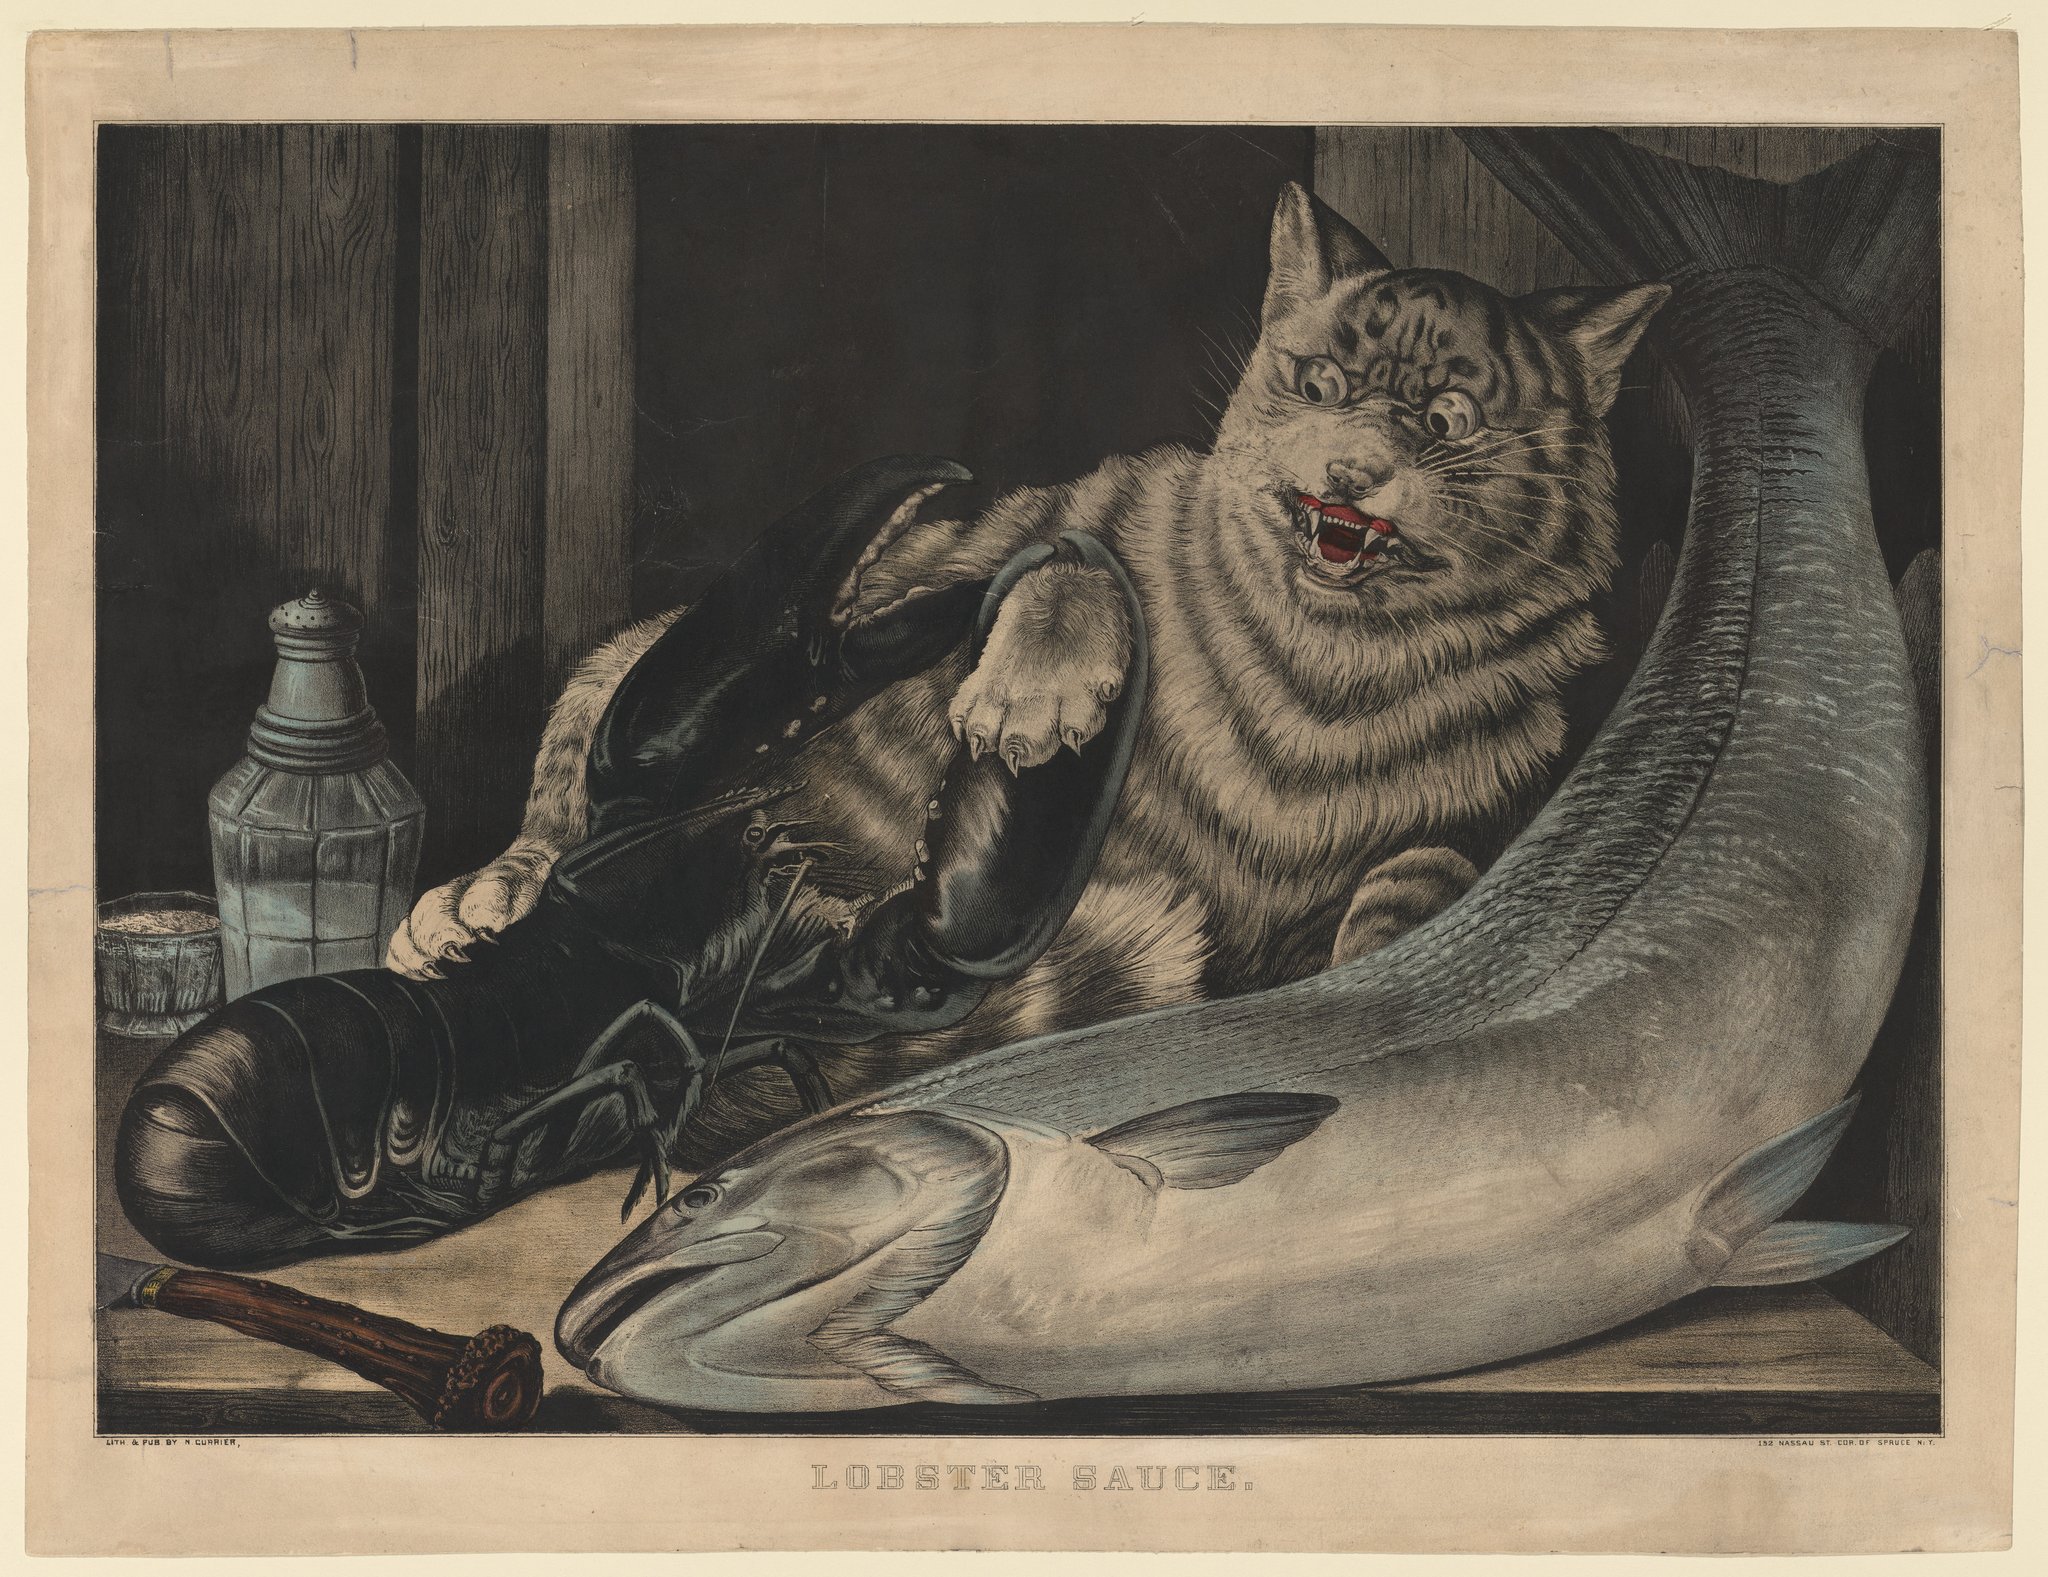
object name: print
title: Lobster Sauce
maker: nathaniel currier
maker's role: publisher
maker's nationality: american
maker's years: 1813-1888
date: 1846-1856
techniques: hand coloring, lithograph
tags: cats,fish,lobsters